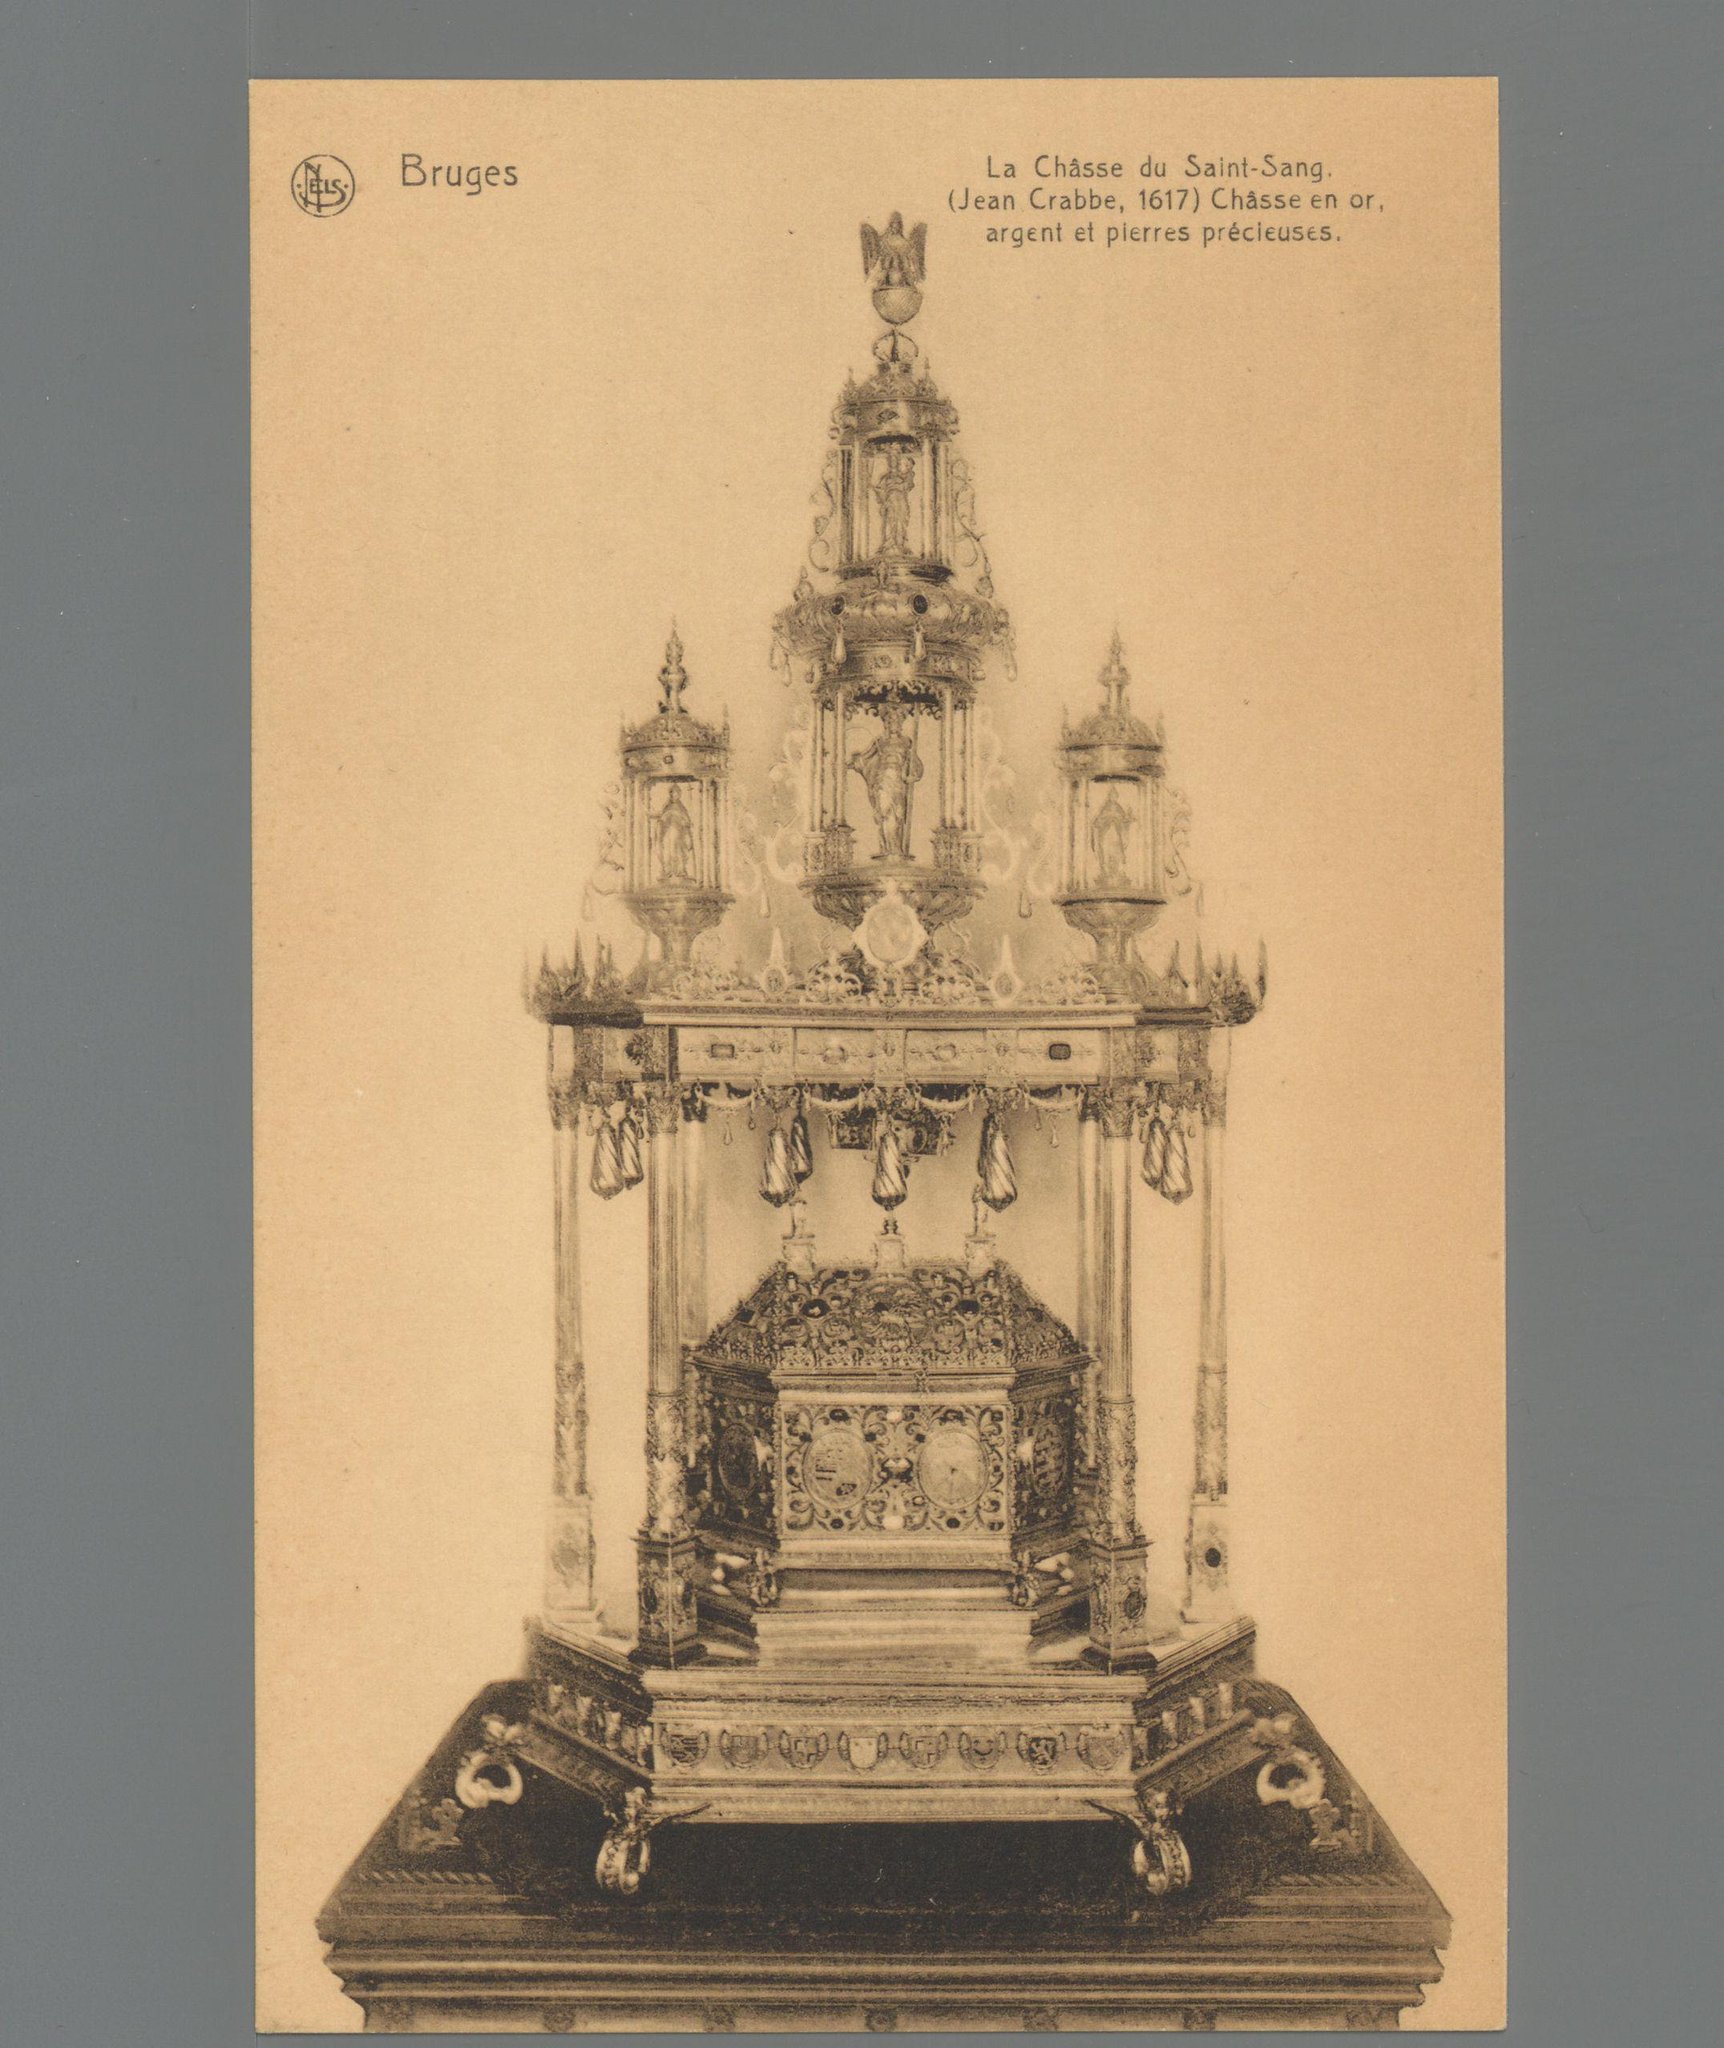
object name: ansichtkaart, prentbriefkaart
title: Bruges. La Châsse du Saint-Sang (Jean Crabbe, 1617). Châsse en or, argent et pierres précieuses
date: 1913-1930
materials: cardboard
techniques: photograph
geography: brussels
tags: relics (and reliquaries)